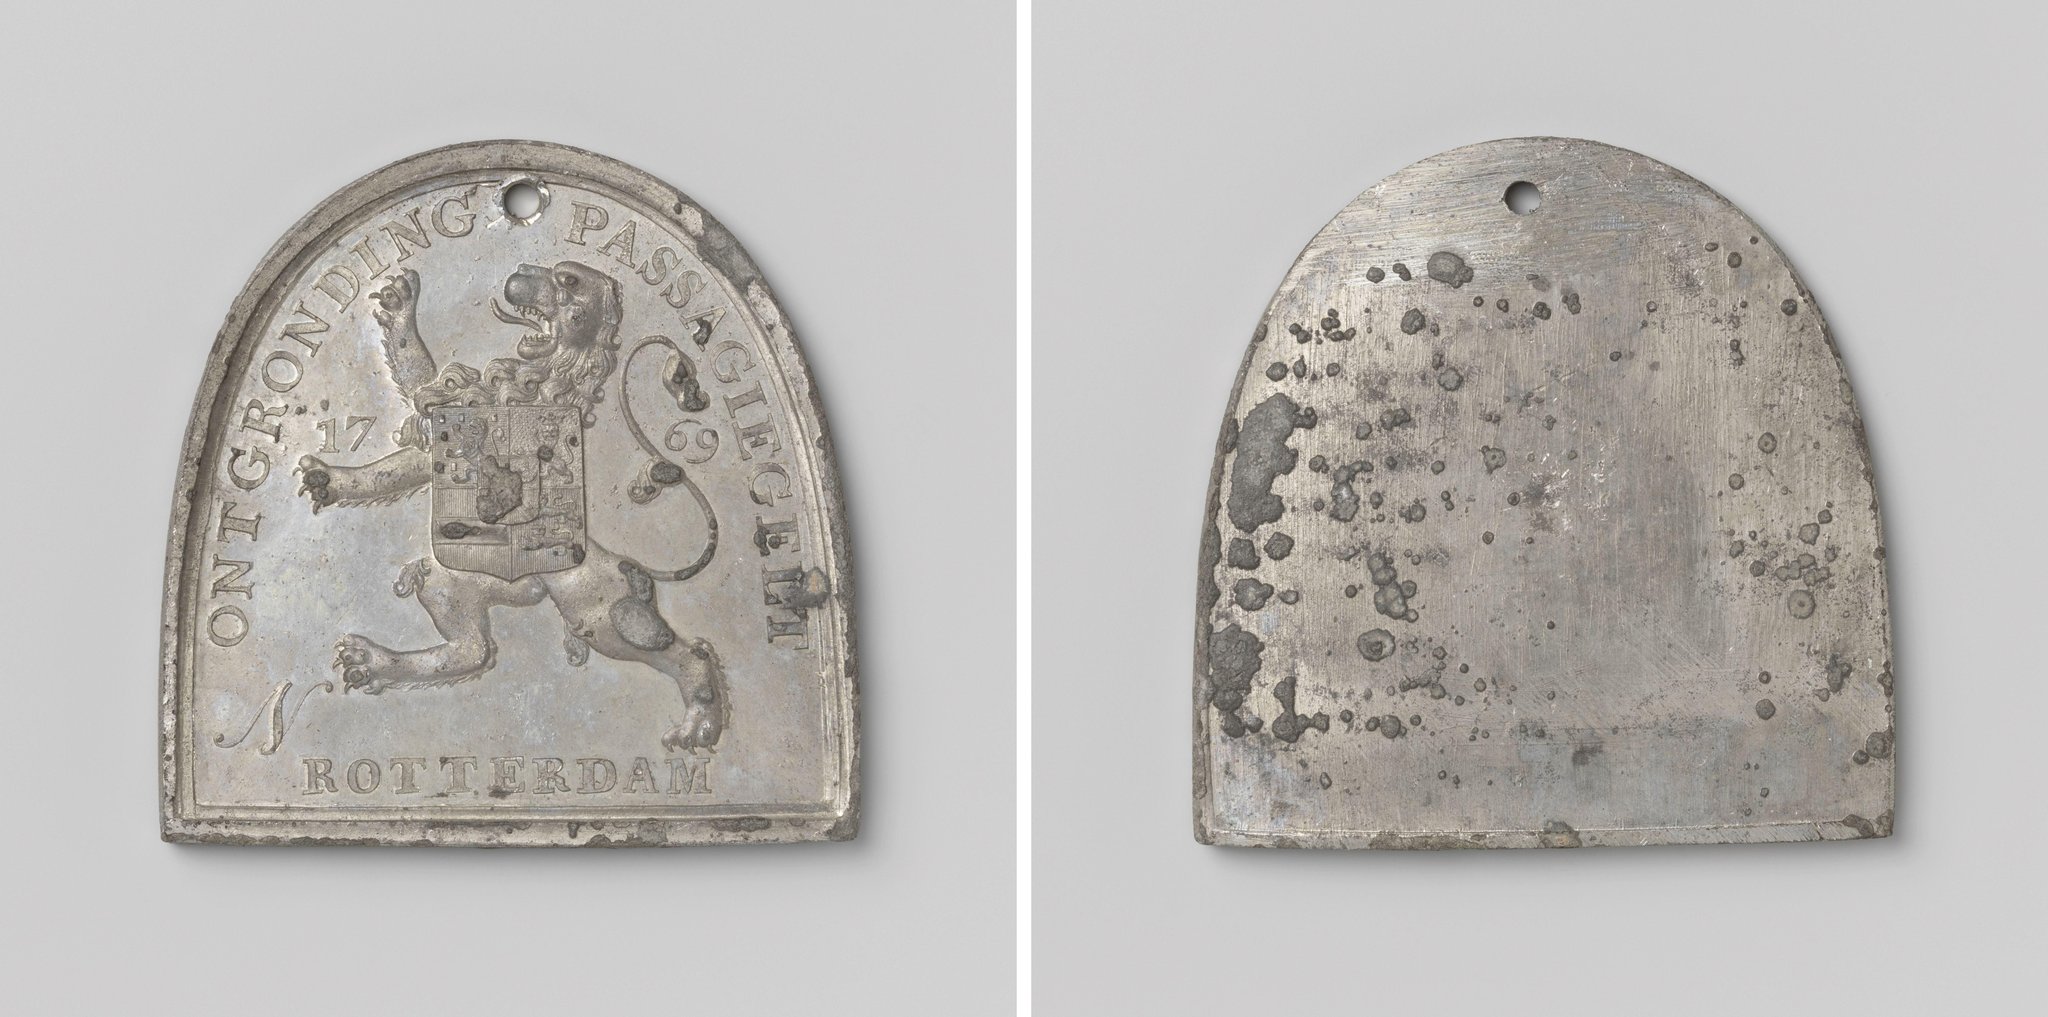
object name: ontgrondingspenning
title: Ontgronding te Rotterdam, penning bedoeld als bewijs voor turfdragers, -vullers of -tonners om turf in te mogen voeren uit de nieuw ontgronde venen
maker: Anonymous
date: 1769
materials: lead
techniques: casting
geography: rotterdam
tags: rotterdam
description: Eenzijdige loden penning met ronde boven- en rechthoekige onderzijde, en gat erin. Voorzijde: staande leeuw met wapenschild op borst tussen jaartal binnen omschrift. Keerzijde: blanco.